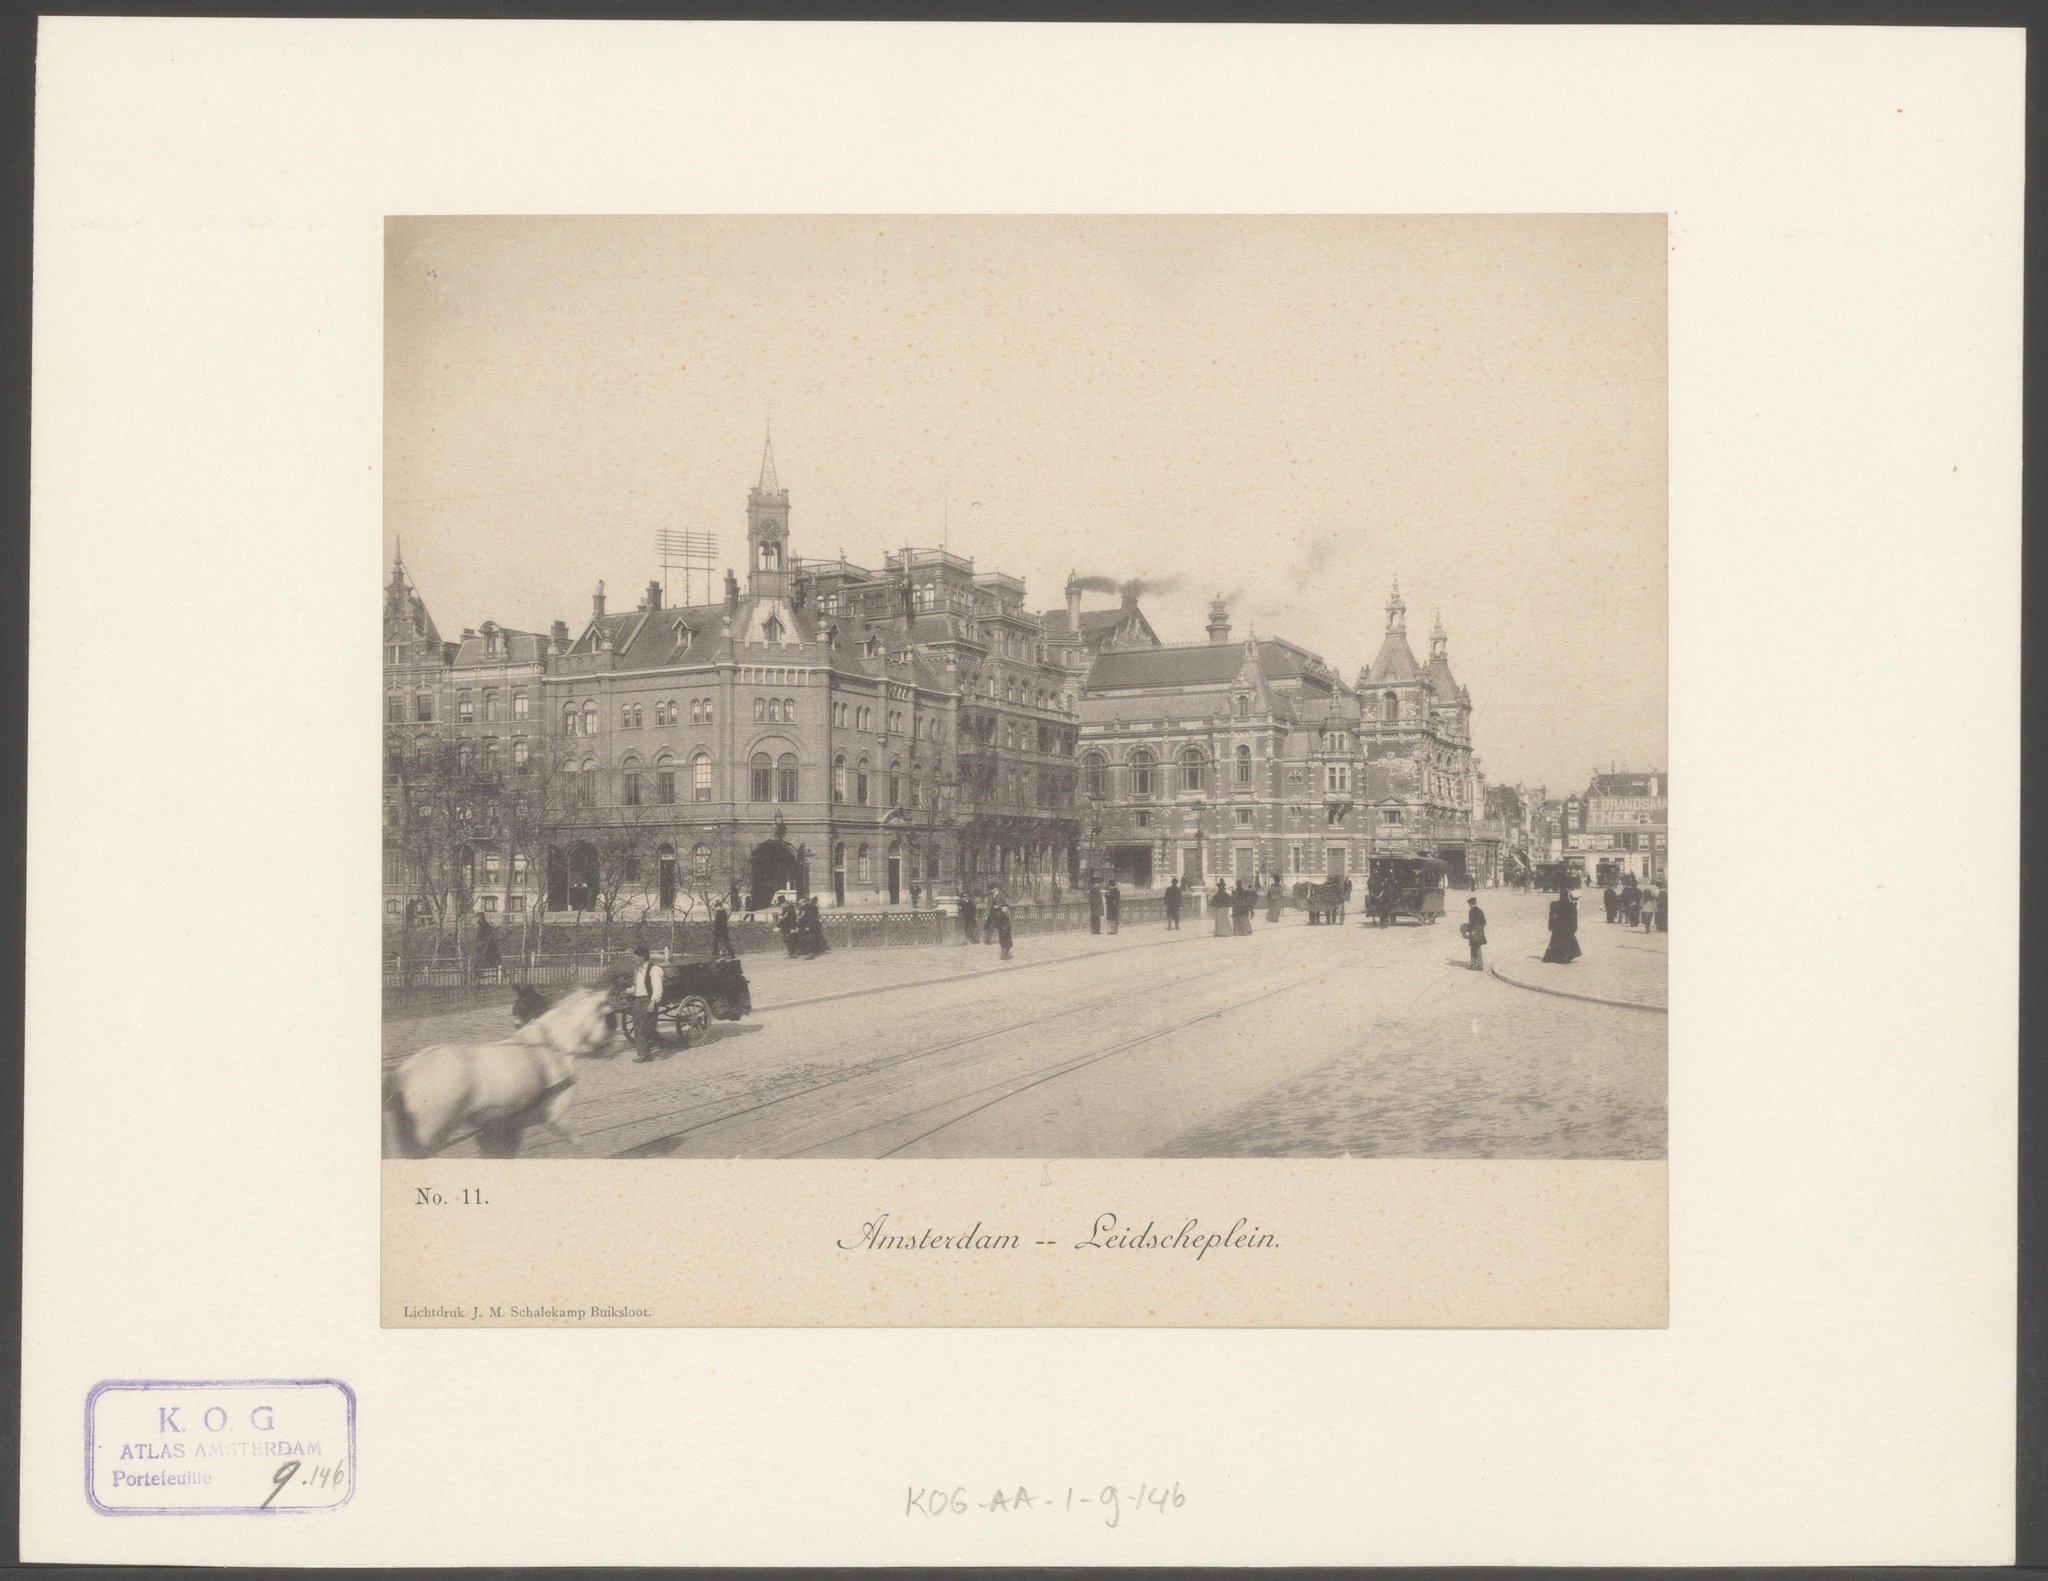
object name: ansichtkaart, prentbriefkaart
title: Gezicht op het Leidseplein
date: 1893-1905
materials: cardboard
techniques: photograph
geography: buiksloot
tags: square, place, circus, etc., city-view in general; 'veduta', theatre (building)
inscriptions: collector's mark: ‘9.146’ Lugt 1641b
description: Onderwerpsrubriek binnen de Atlas Amsterdam: 2e Laurierdwarsstraat (Vuile Weespad), Leidschegracht, Leidschekade, Leidscheplein, Leidschestraat, v. Lennepkade, Lijnbaansgracht, Lauriergracht, Leliedwarsstraat, Leliegracht, Lindengracht, Lombardsteeg, Looiersgracht, Looiersstraat (Nieuwe), Leidekkerssteeg.